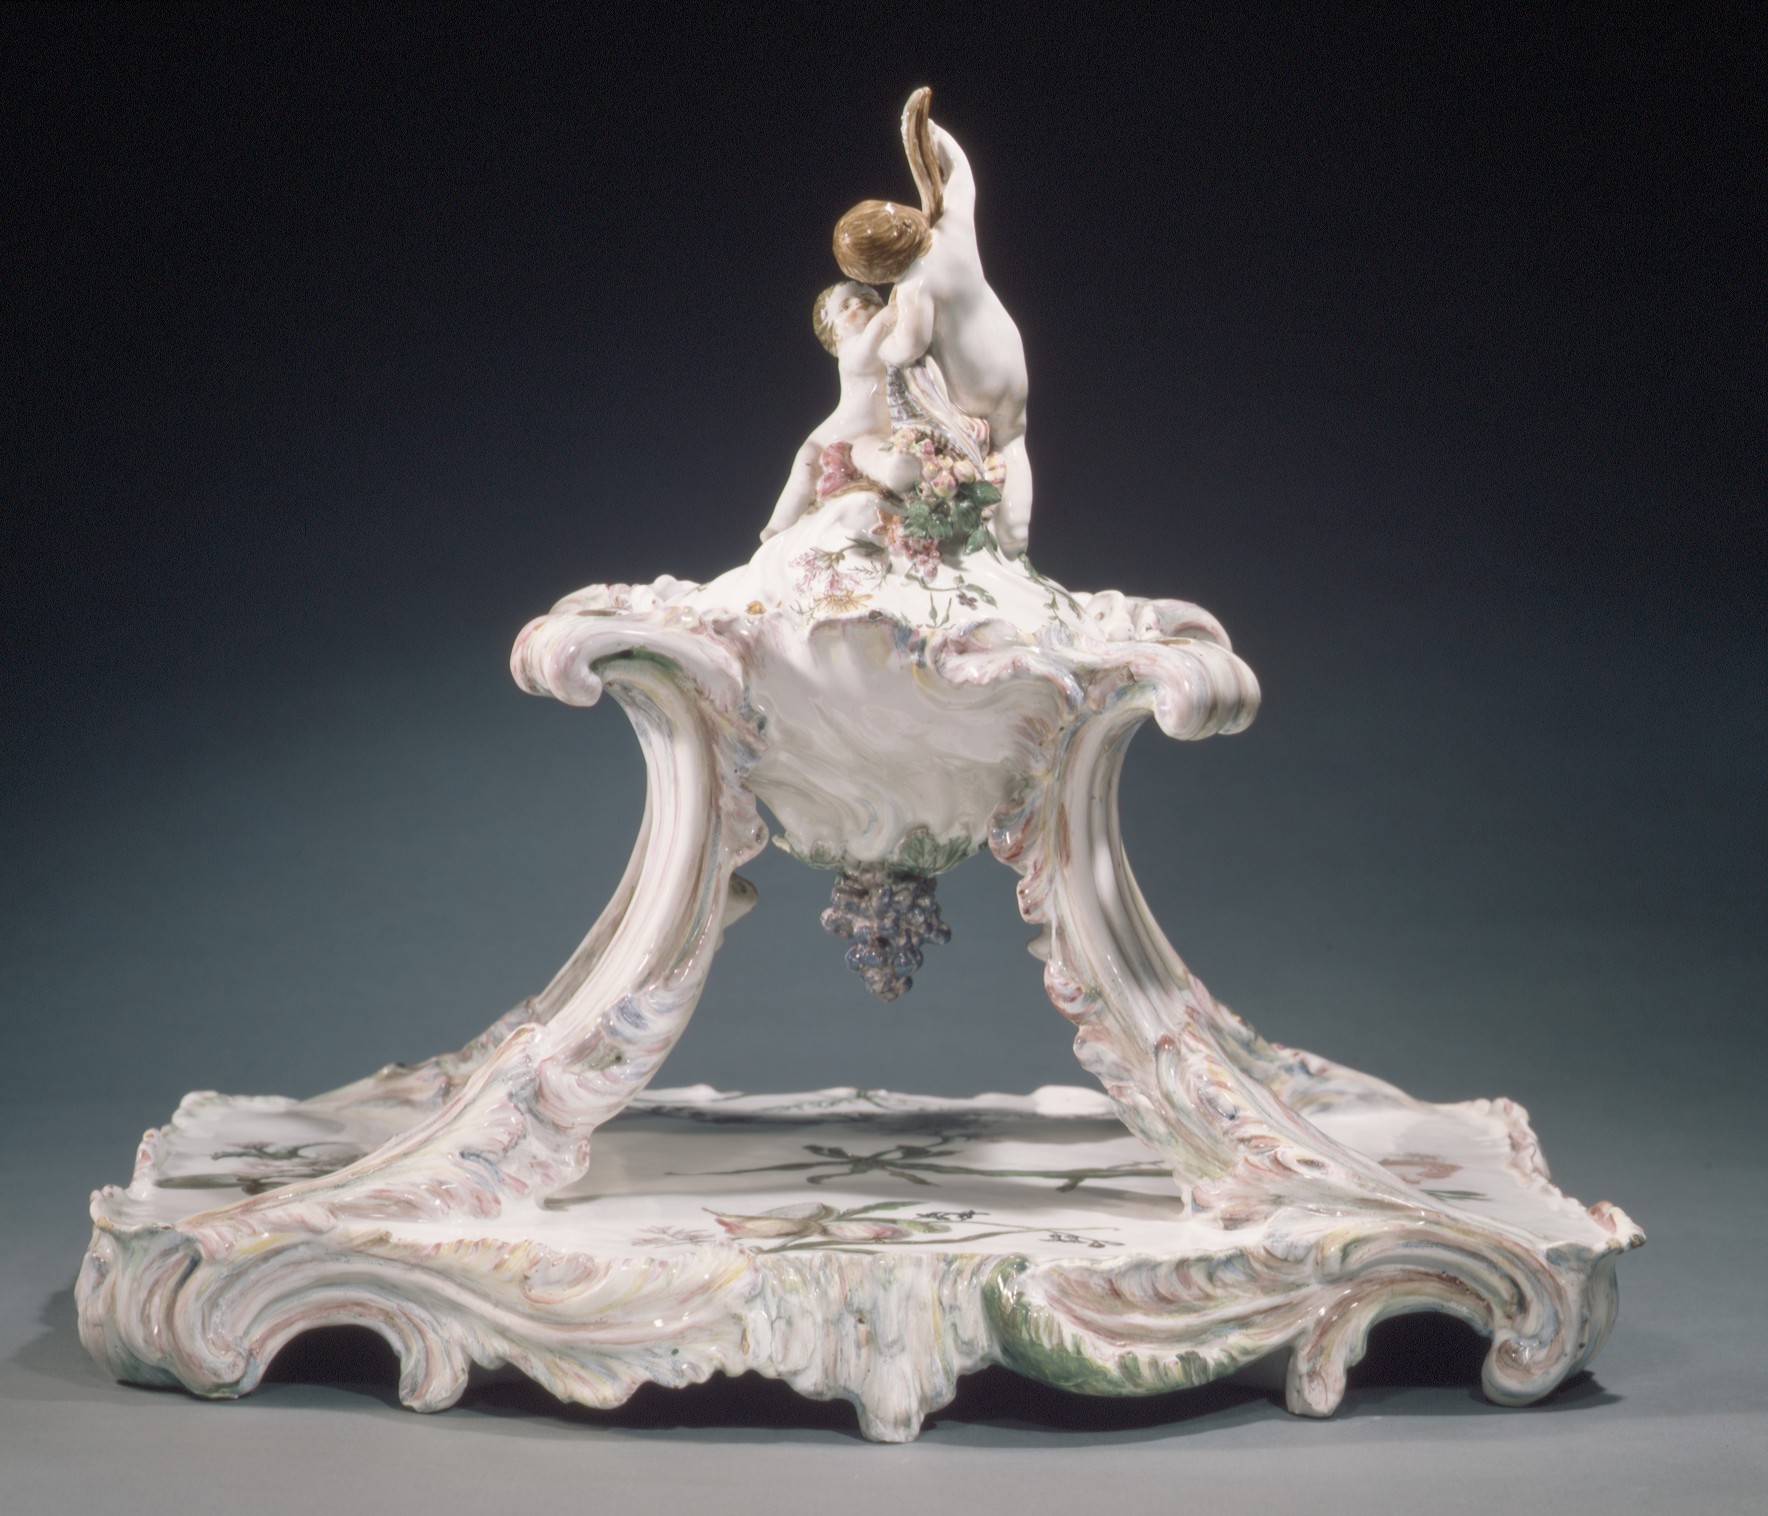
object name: centerpiece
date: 1755-1760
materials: faience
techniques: glazing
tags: infants